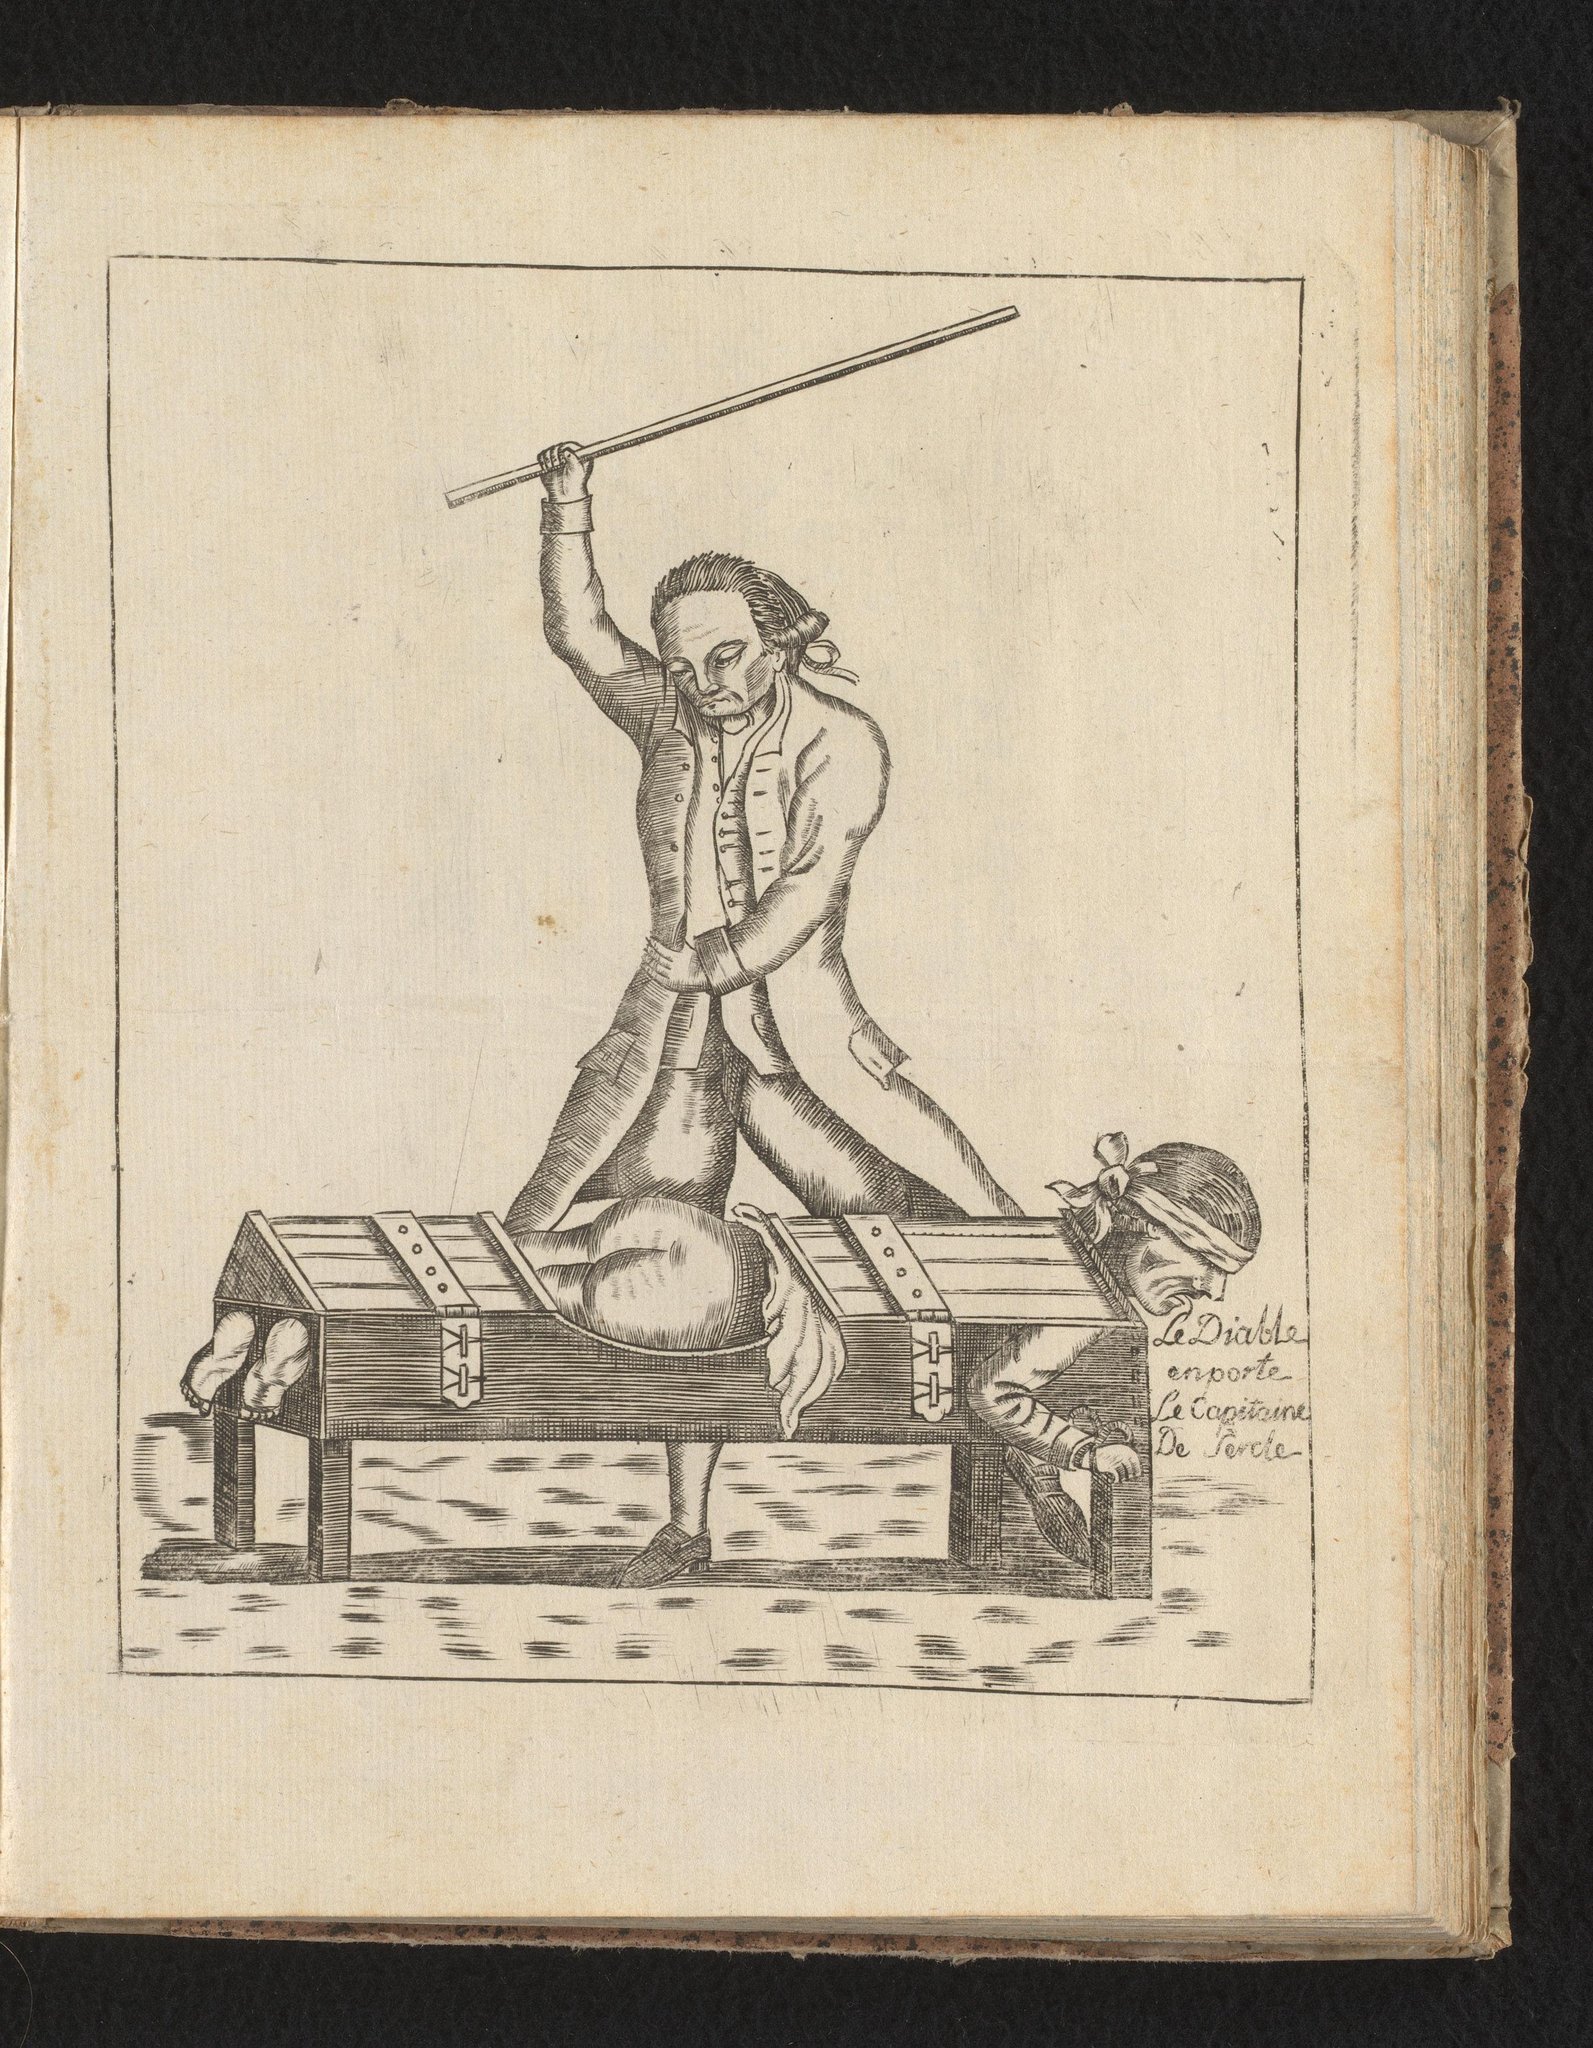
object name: print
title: Geseling van een man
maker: Anonymous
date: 1787-1790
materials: paper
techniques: engraving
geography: southern netherlands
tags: torture, spanking, drubbing (of naughty children), brabant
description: Spotprent waarin een geblinddoekte man geketend in een kist met een stok op zijn naakte billen wordt geslagen. Onderdeel van de gebundelde verzameling prenten betrekking hebbend op de gebeurtenissen van de Brabantse Omwenteling en de periode 1787-1790.